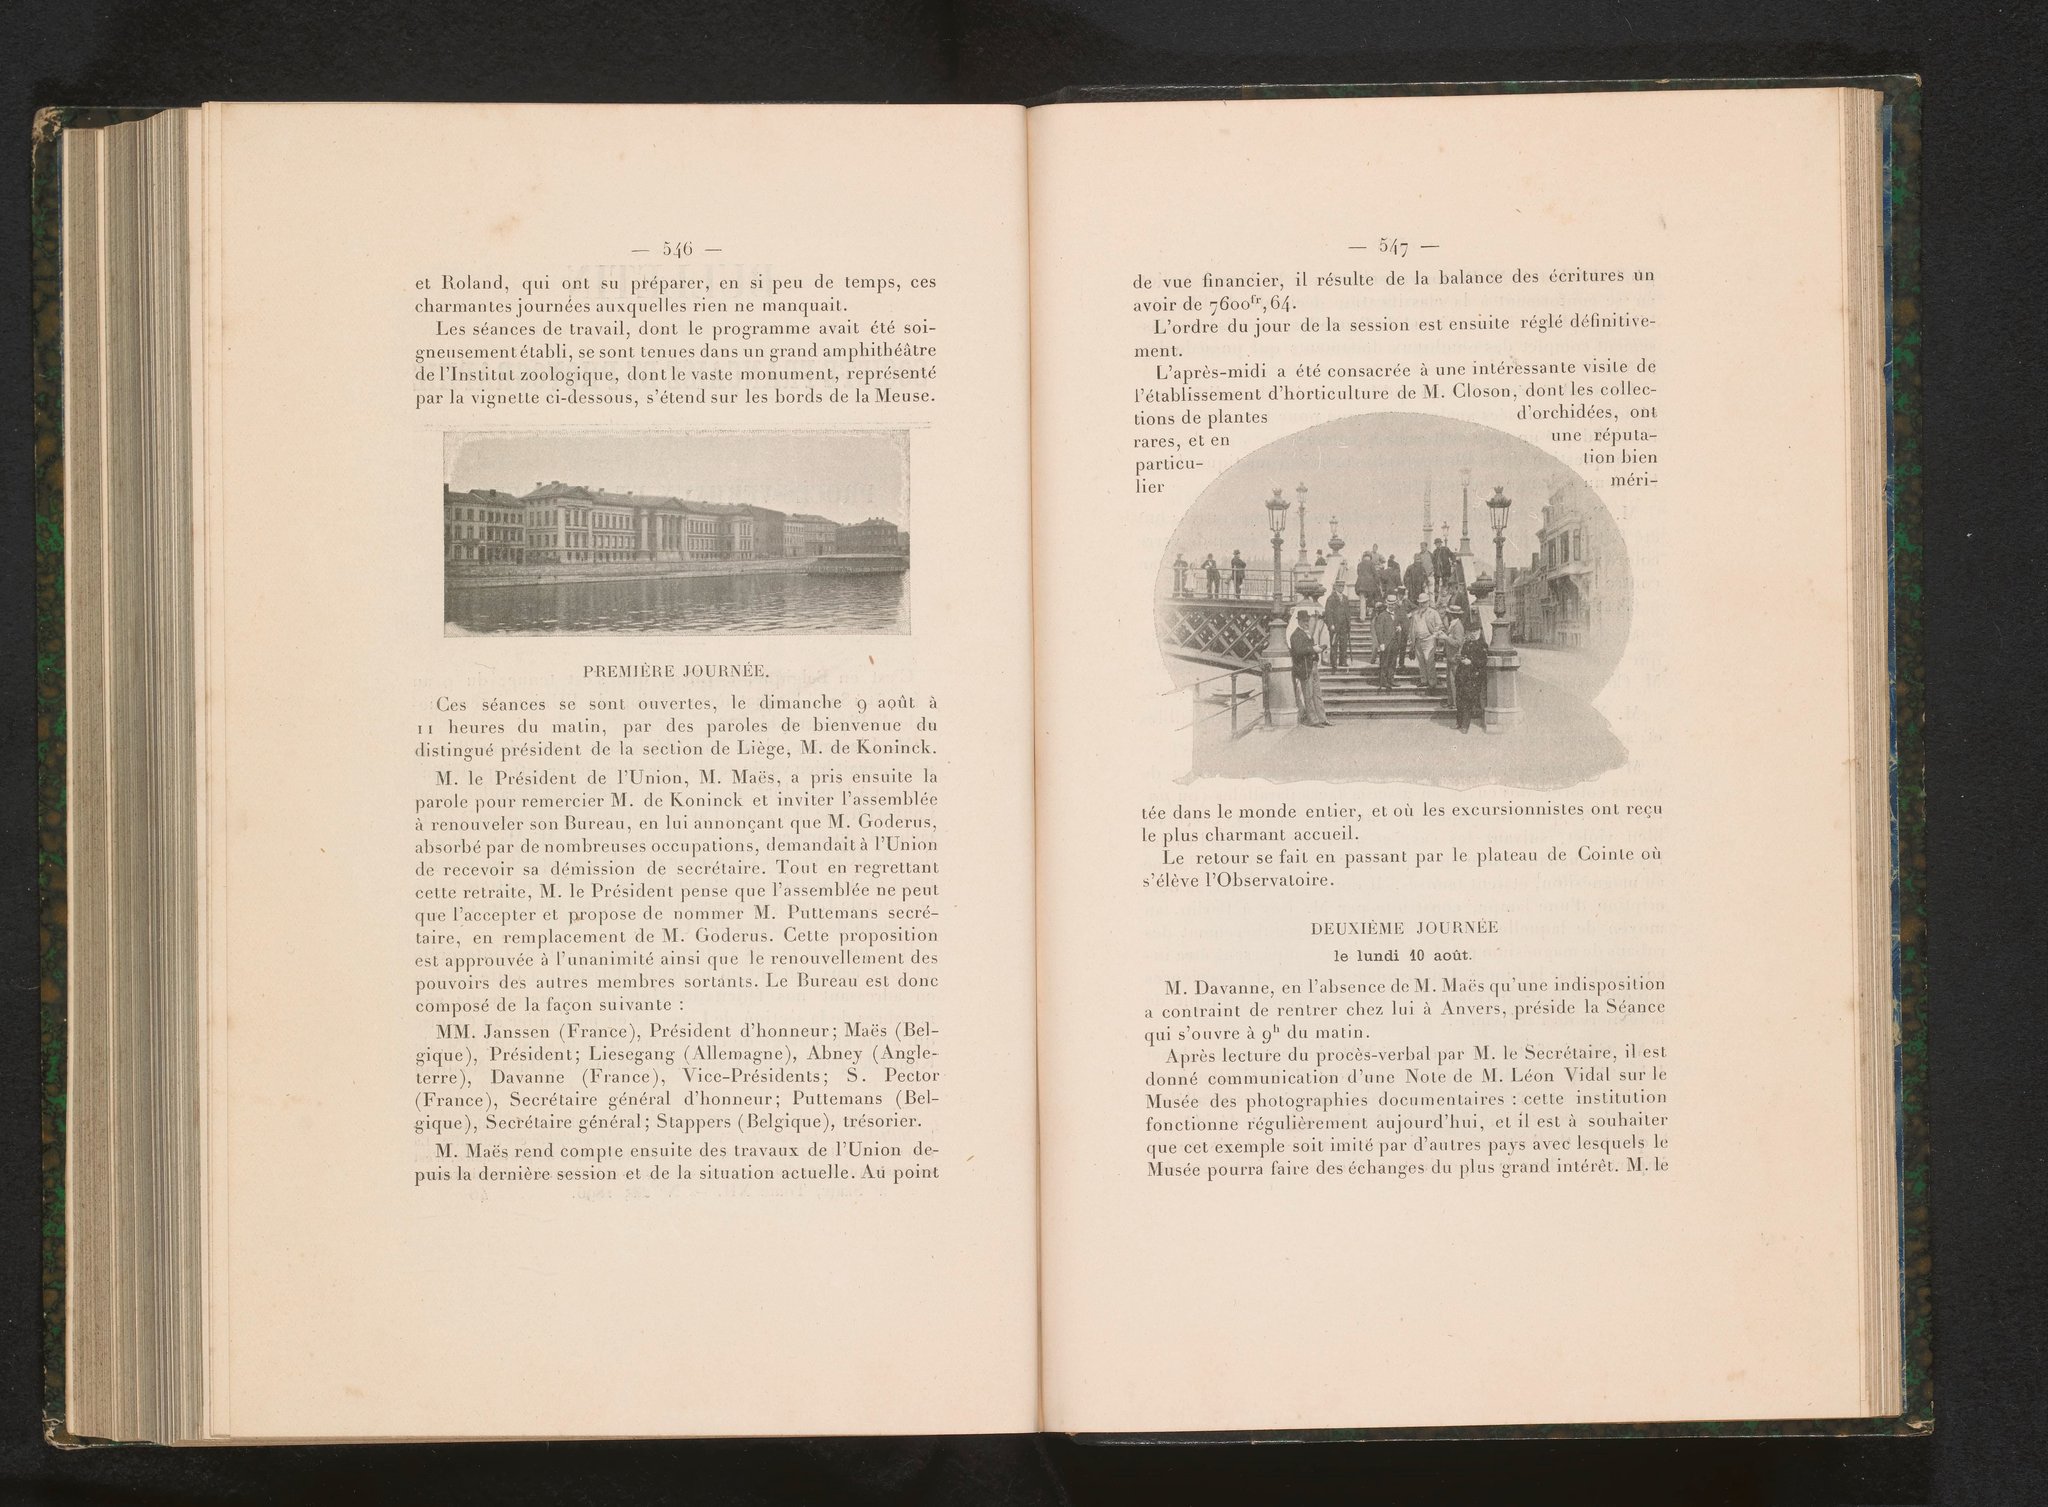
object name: page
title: Gezicht op een gebouw (vermoedelijk) te Luik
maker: Anonymous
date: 1896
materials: paper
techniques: autotype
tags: river, façade (of house or building)